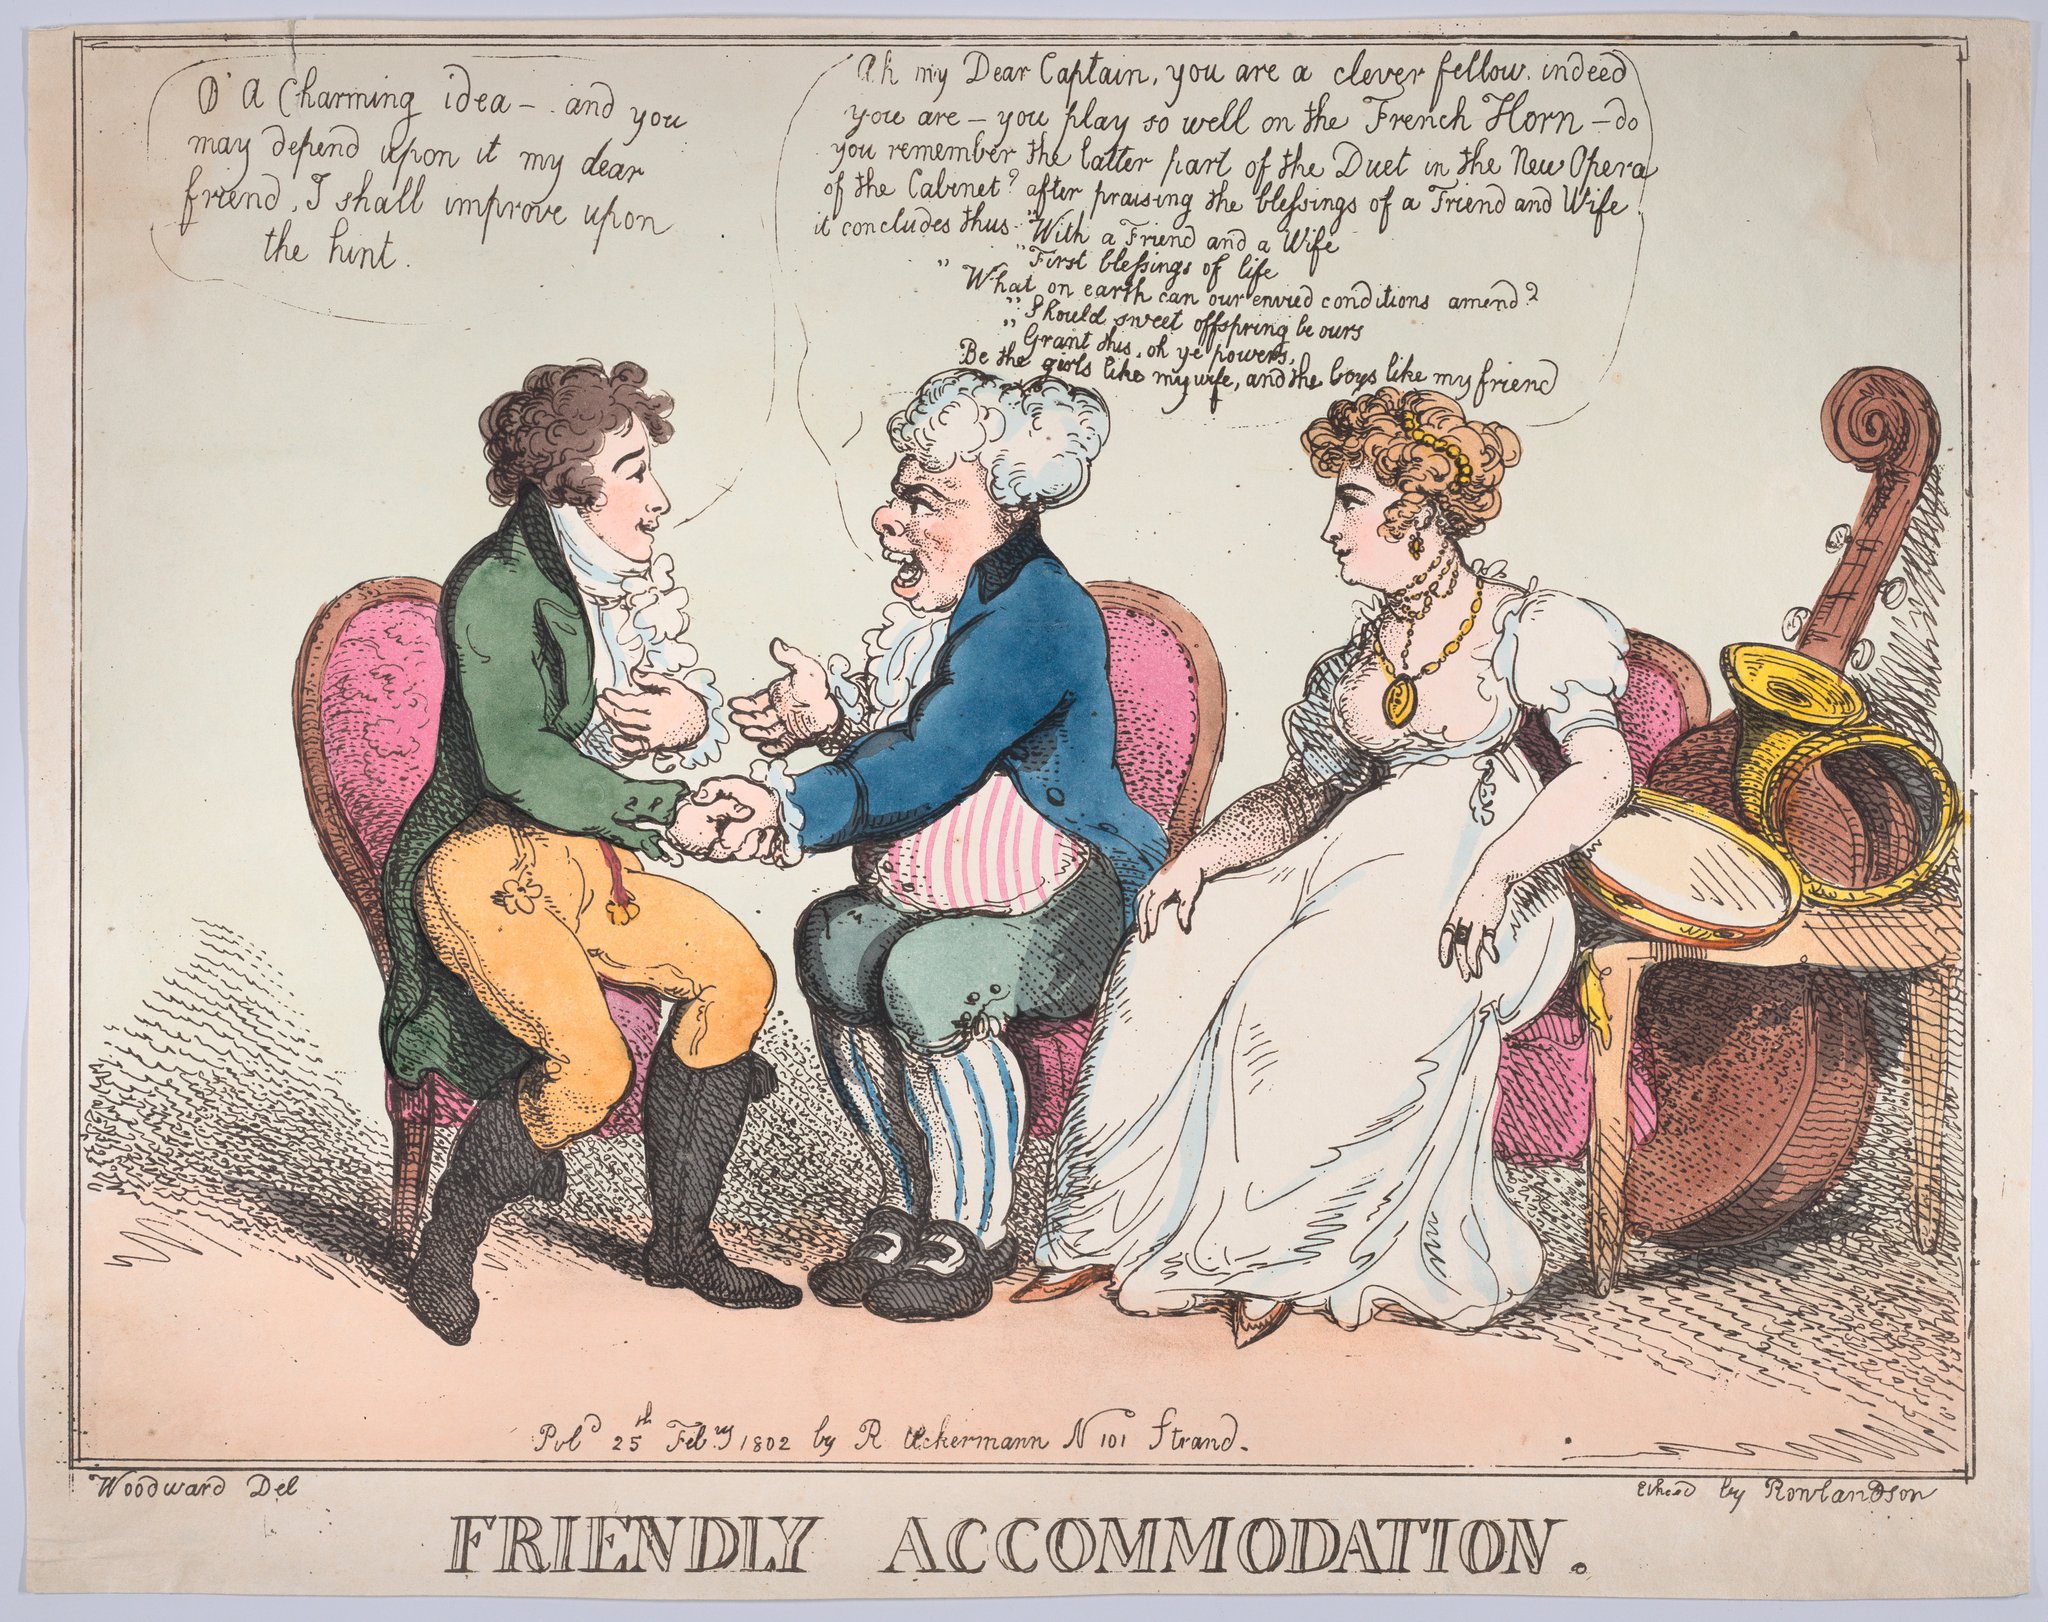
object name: print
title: Friendly Accommodation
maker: thomas rowlandson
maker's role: artist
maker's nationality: british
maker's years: 1757-1827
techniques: etching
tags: musical instruments,satire,men,women